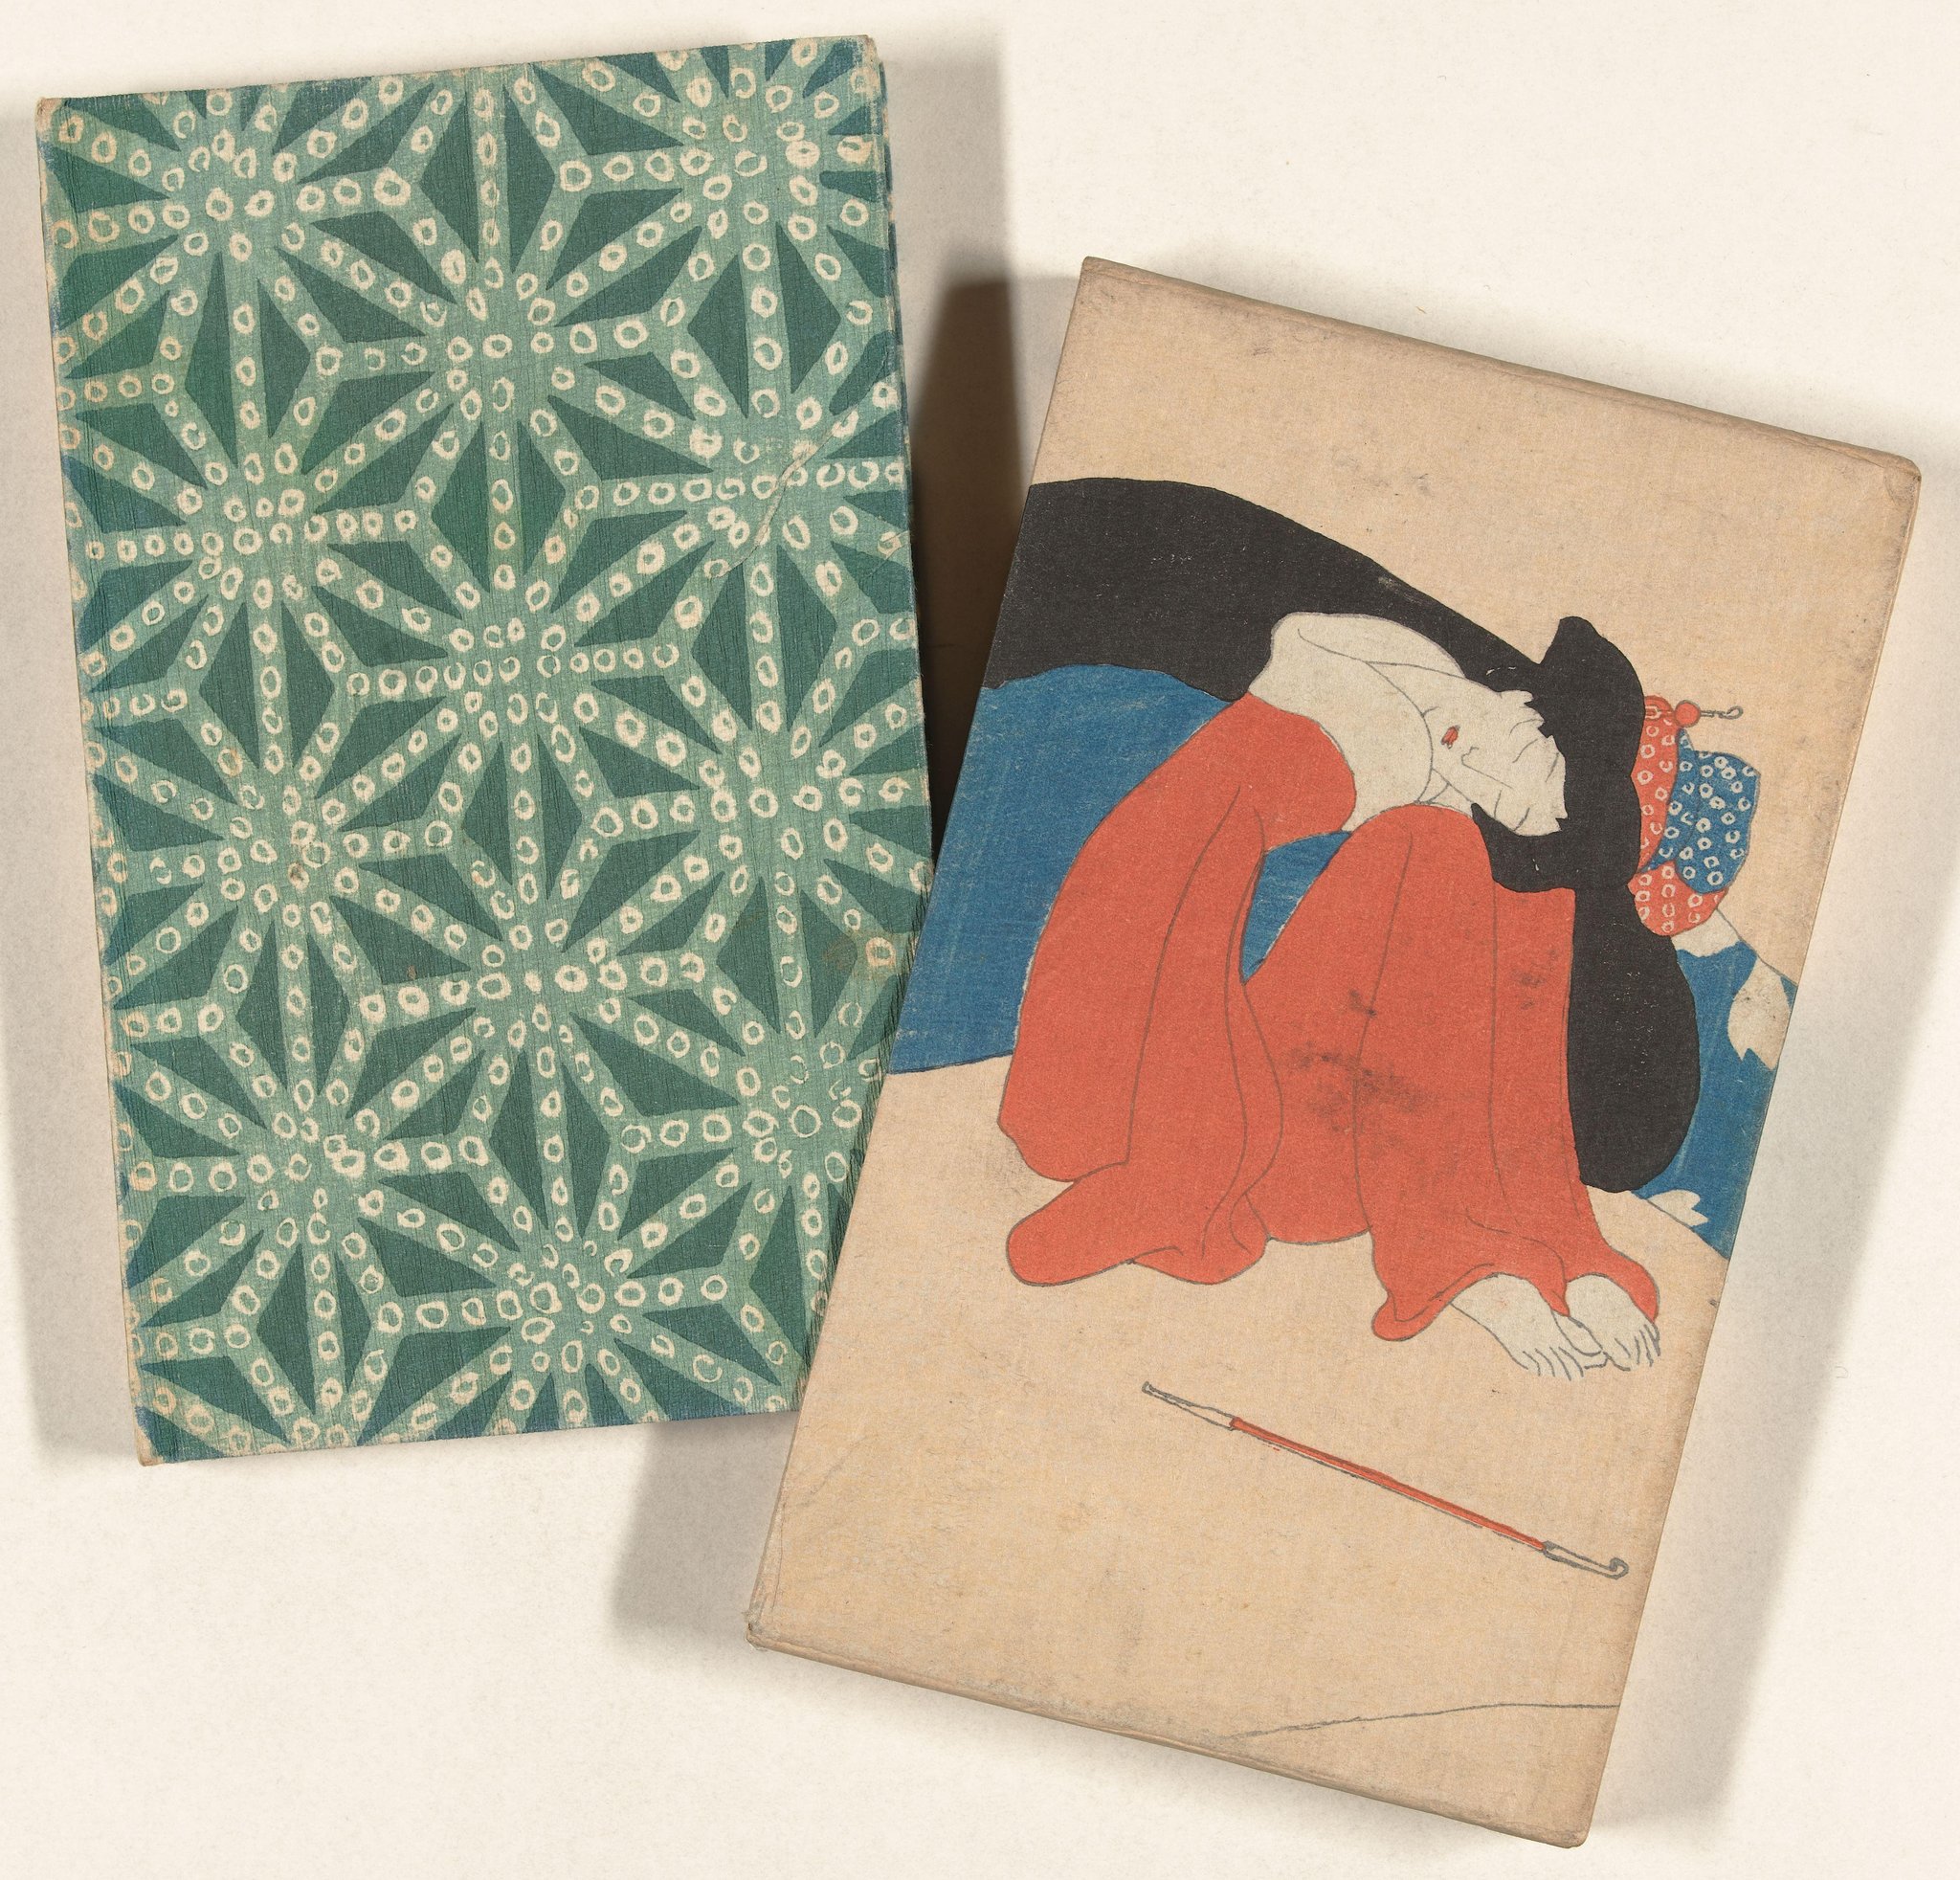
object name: book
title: Ochtendkapsel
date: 1903-1919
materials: paper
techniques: woodcut, letterpress printing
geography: tokyo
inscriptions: date